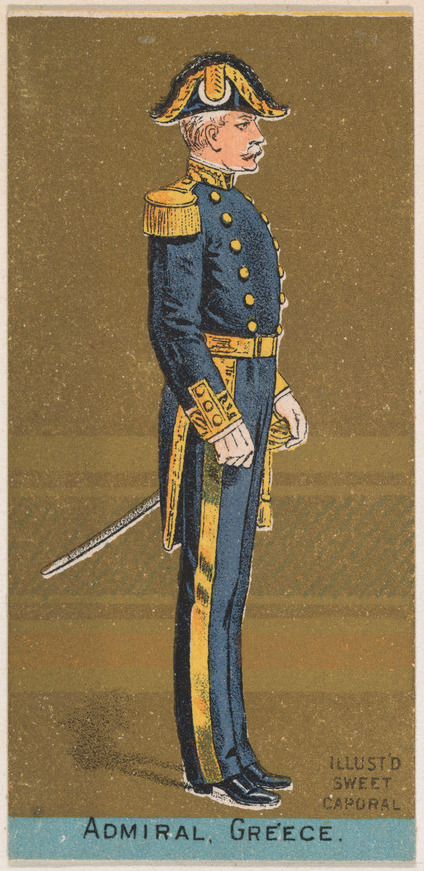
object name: print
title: Admiral, Greece, from the Military Series (N224) issued by Kinney Tobacco Company to promote Sweet Caporal Cigarettes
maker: kinney brothers tobacco company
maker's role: publisher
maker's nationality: american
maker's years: 1869-2011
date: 1888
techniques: color lithograph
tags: military,men,profiles,admirals